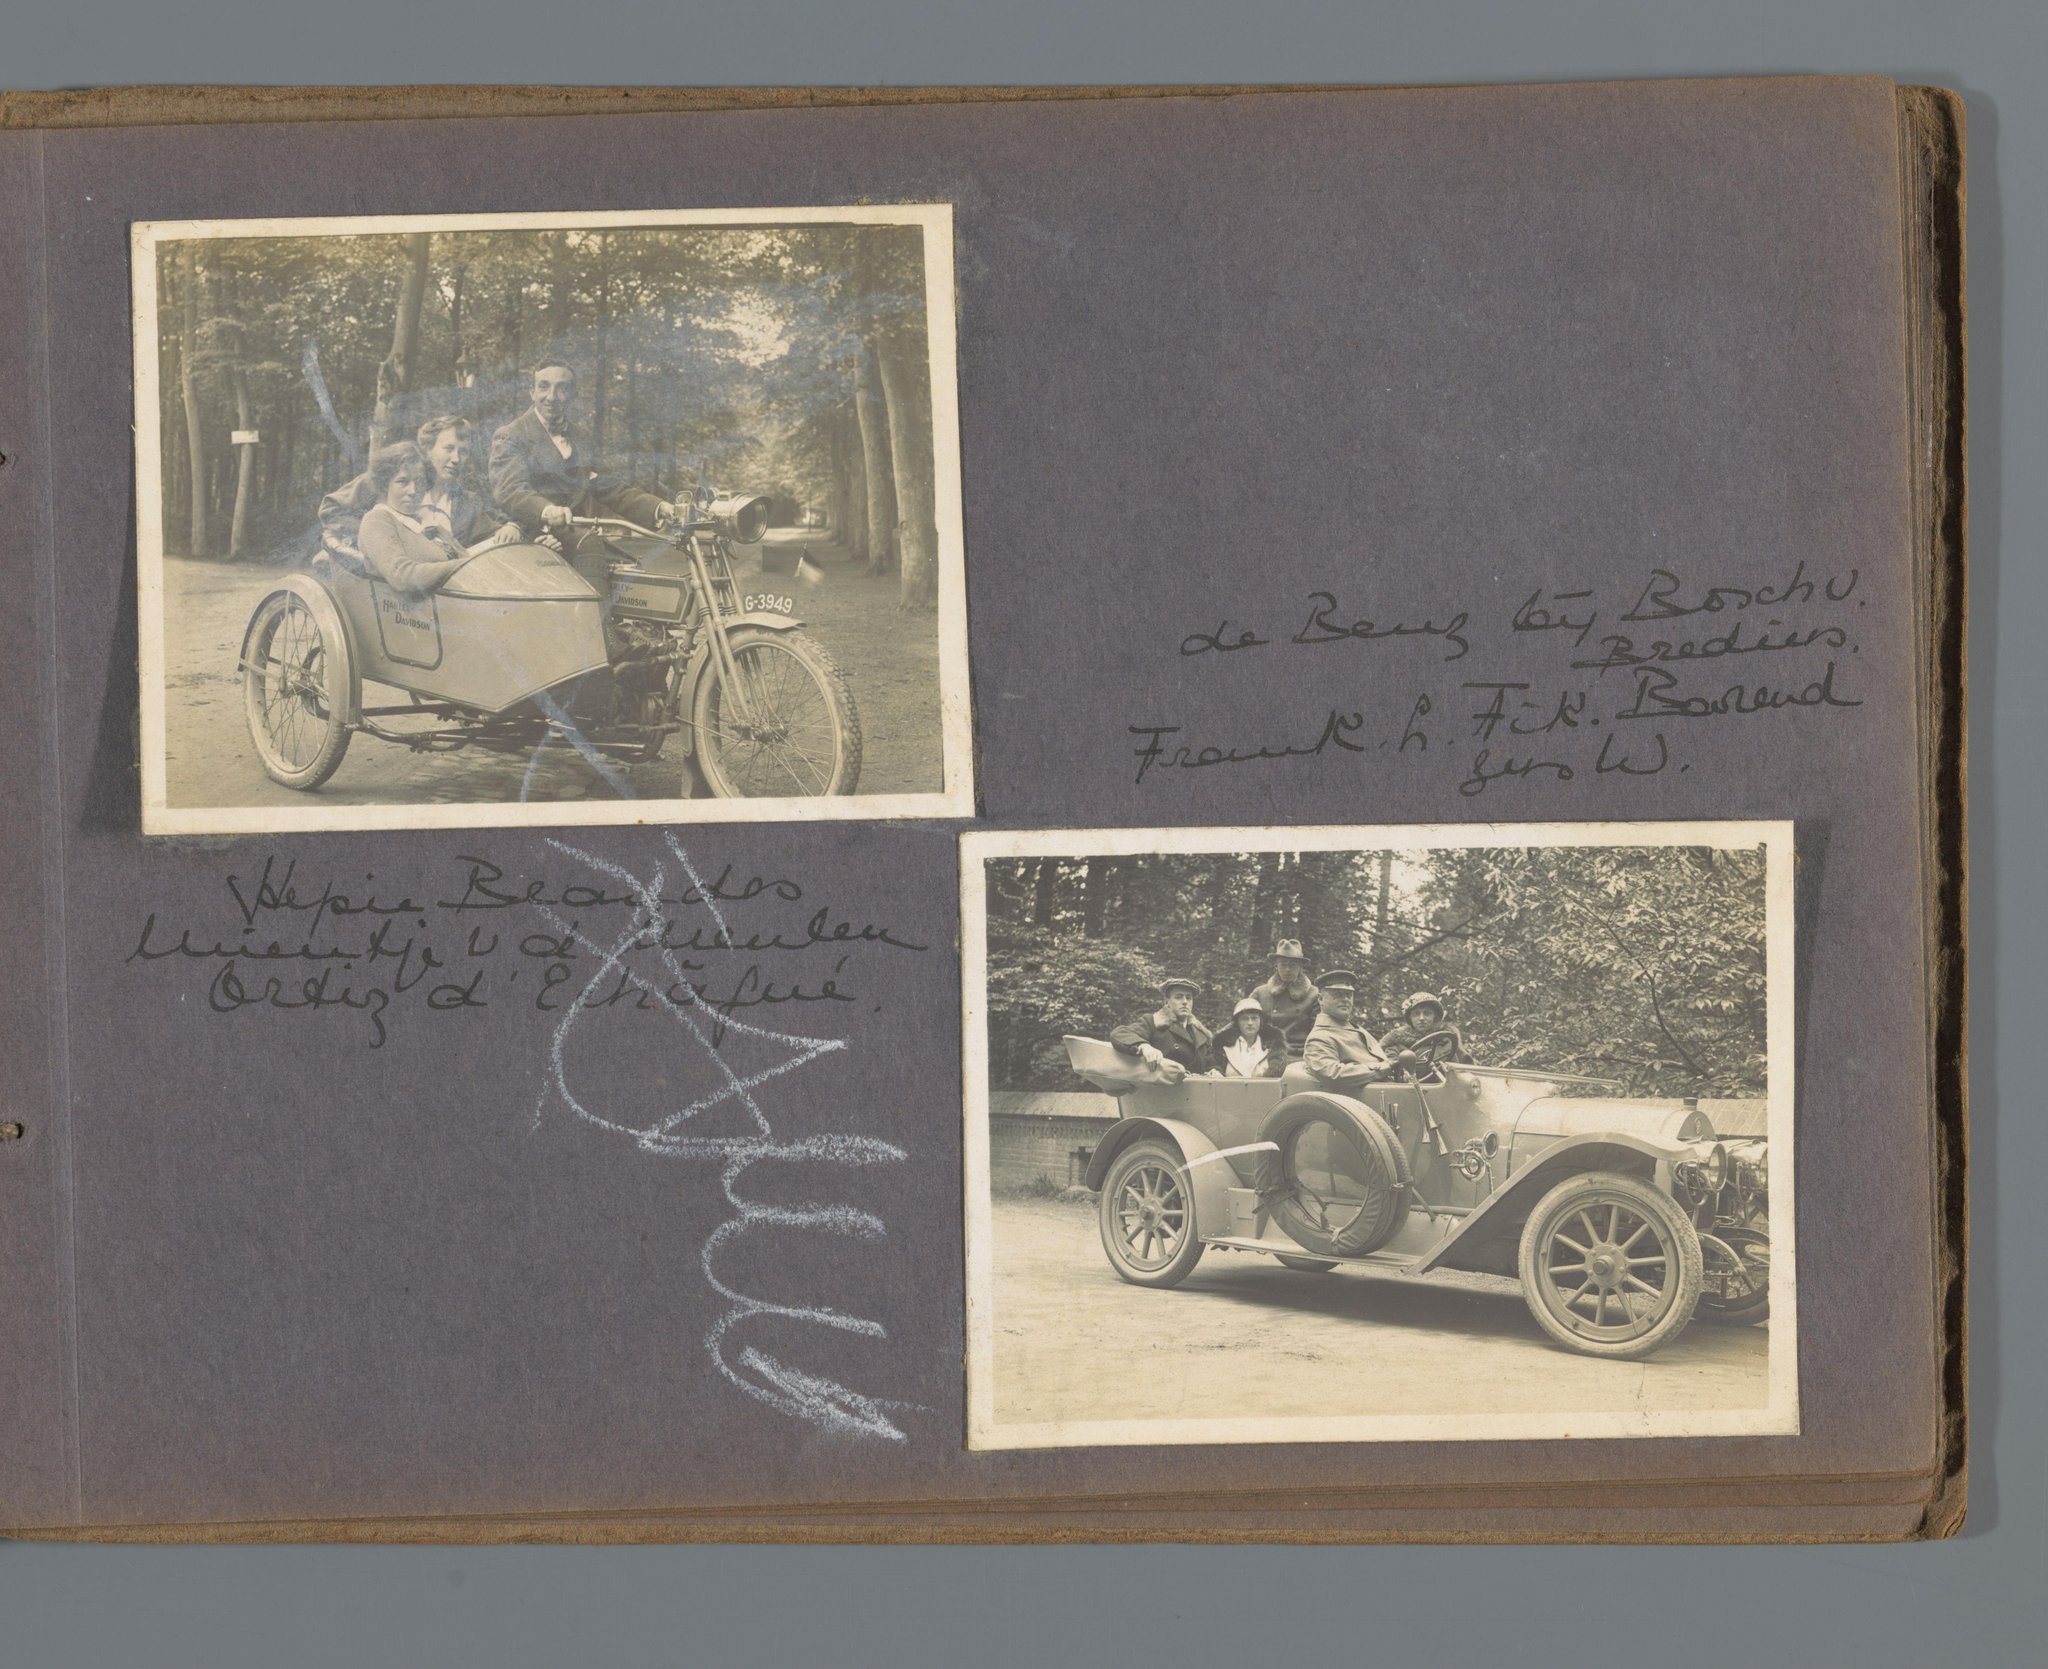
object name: photograph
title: Mensen op een motorfiets, waaronder Hepia Beaudes [?], Mientje van der Meulen en Ortez d'Echafué, en in een auto, met Frank L., Fik Bareud en Gus W.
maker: carolina frederika onnen (lien/loen)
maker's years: 1896-1983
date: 1914-1915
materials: paper, cardboard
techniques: gelatin silver print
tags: motor-cycles and other two-wheeled motor-vehicles, automobile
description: Deze foto's zijn onderdeel van een album.